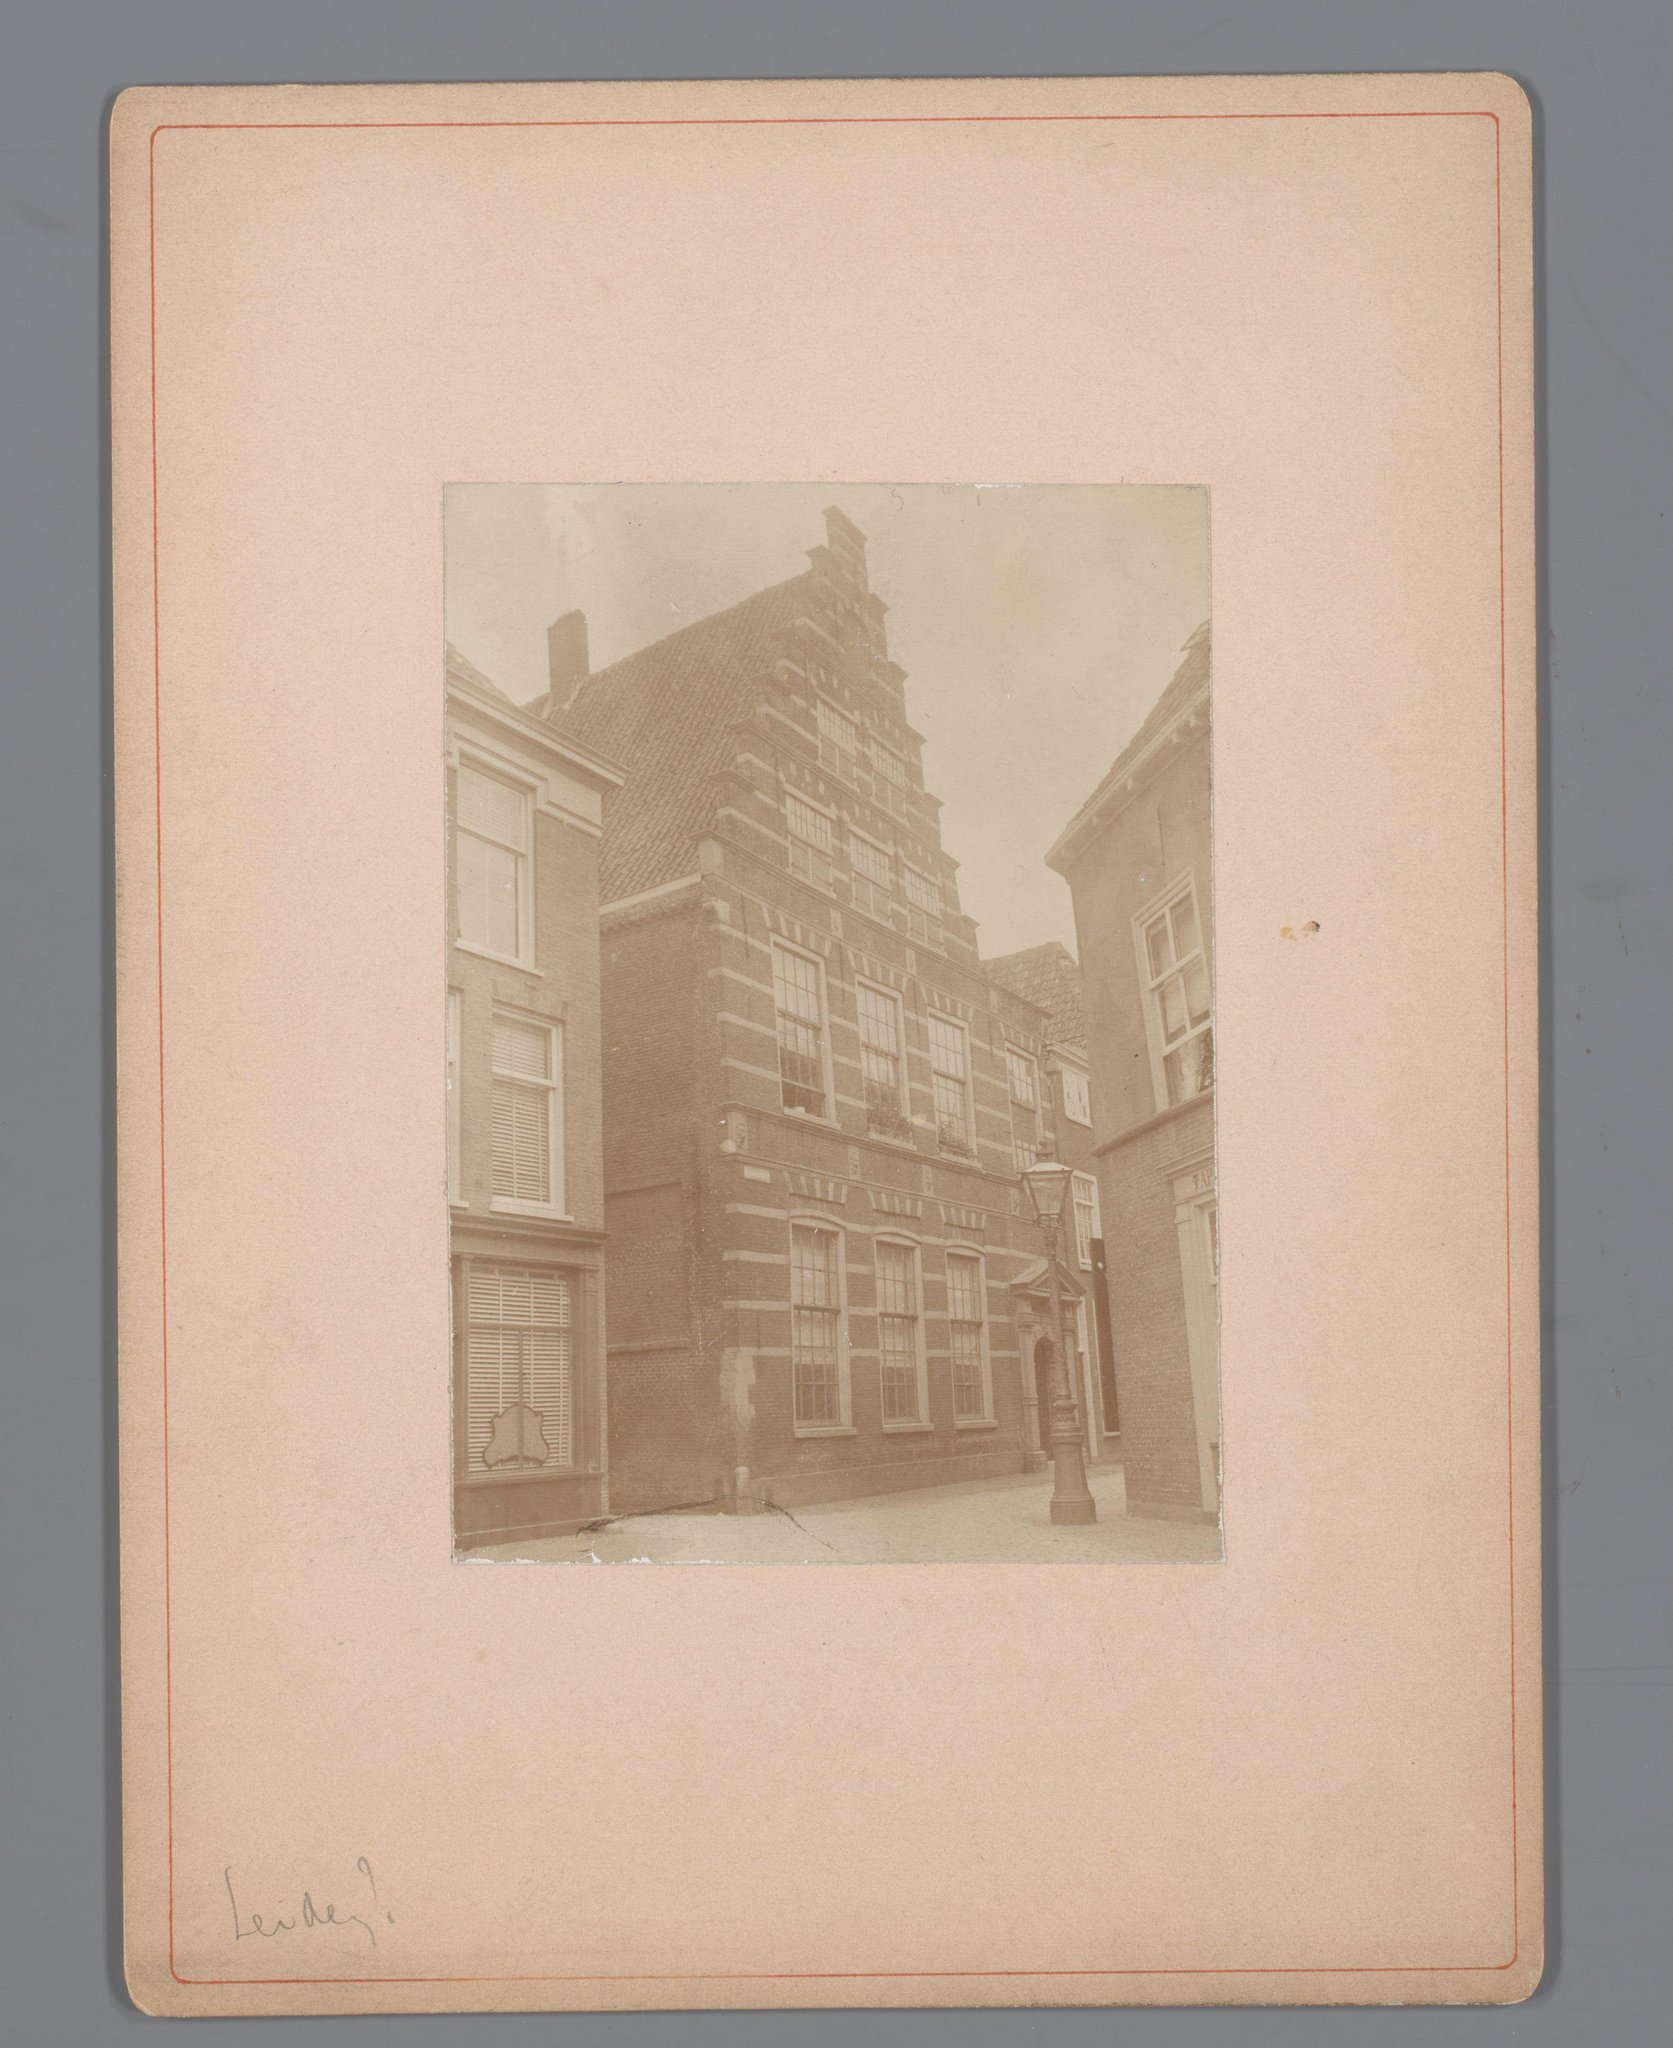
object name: photograph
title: Gezicht op de Latijnse School te Leiden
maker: Anonymous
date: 1882-1914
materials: cardboard, photographic support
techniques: collodion silver print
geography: leiden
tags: secondary education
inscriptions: annotation: ‘Leiden?’, annotation: ‘Latijnse School’